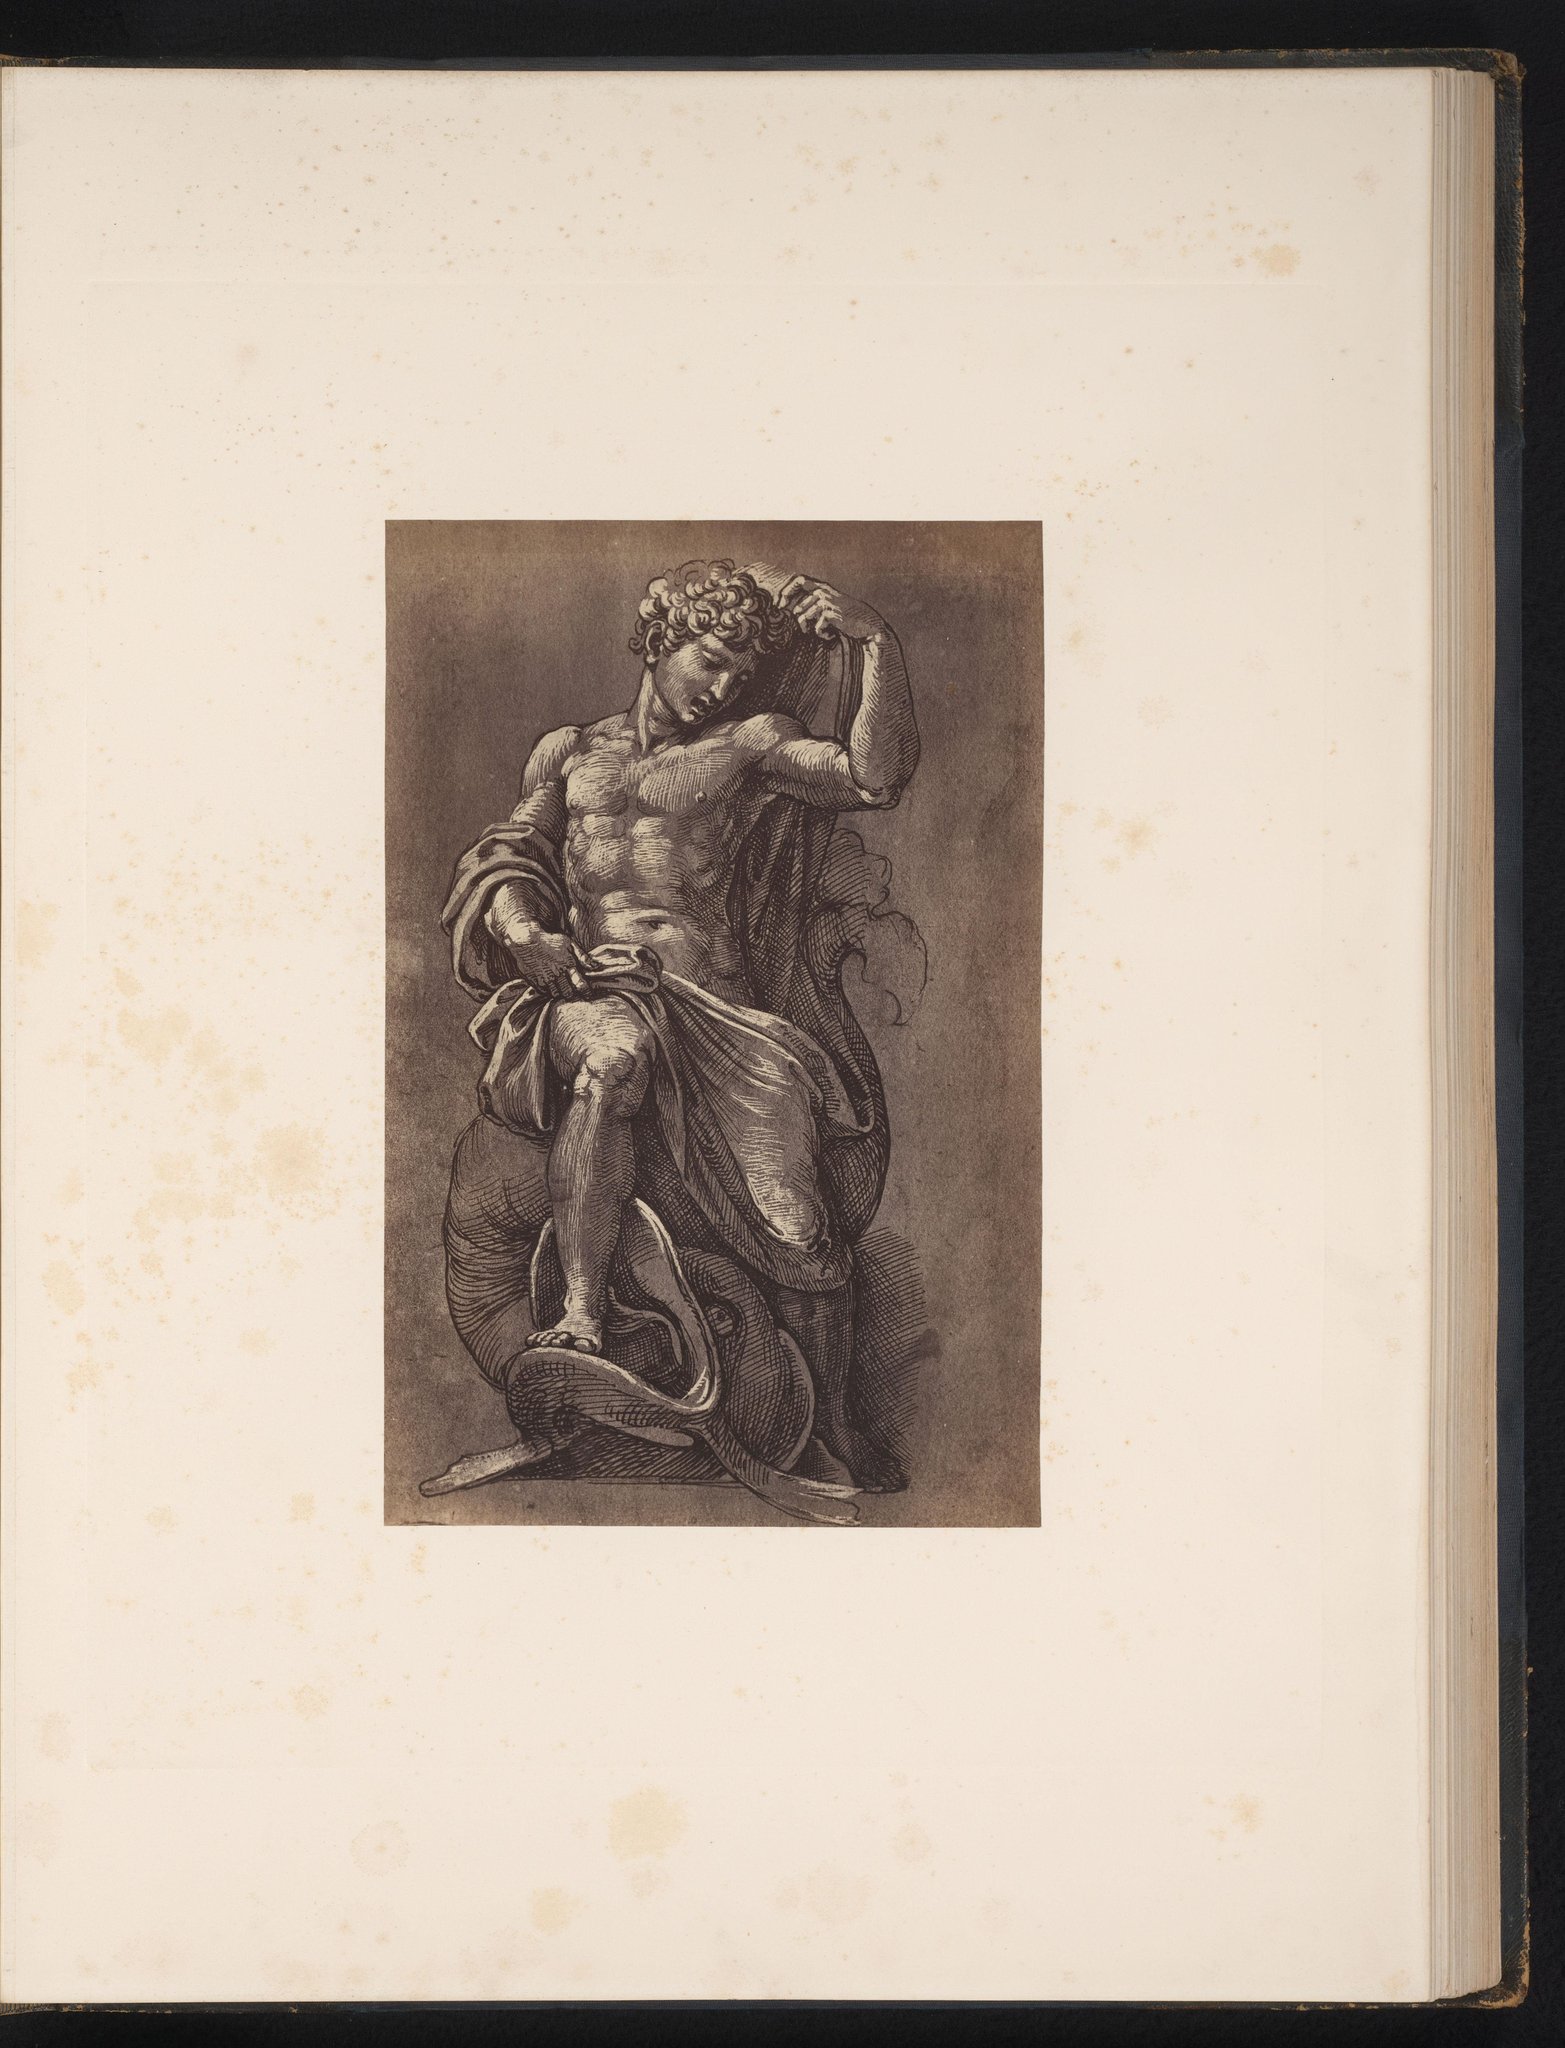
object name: reproduction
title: Fotoreproductie van een tekening van Giovanni Francesco Penni, figuurstudie van een man staand op een vis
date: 1852-1857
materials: paper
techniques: albumen print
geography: windsor castle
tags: adult man, fishes